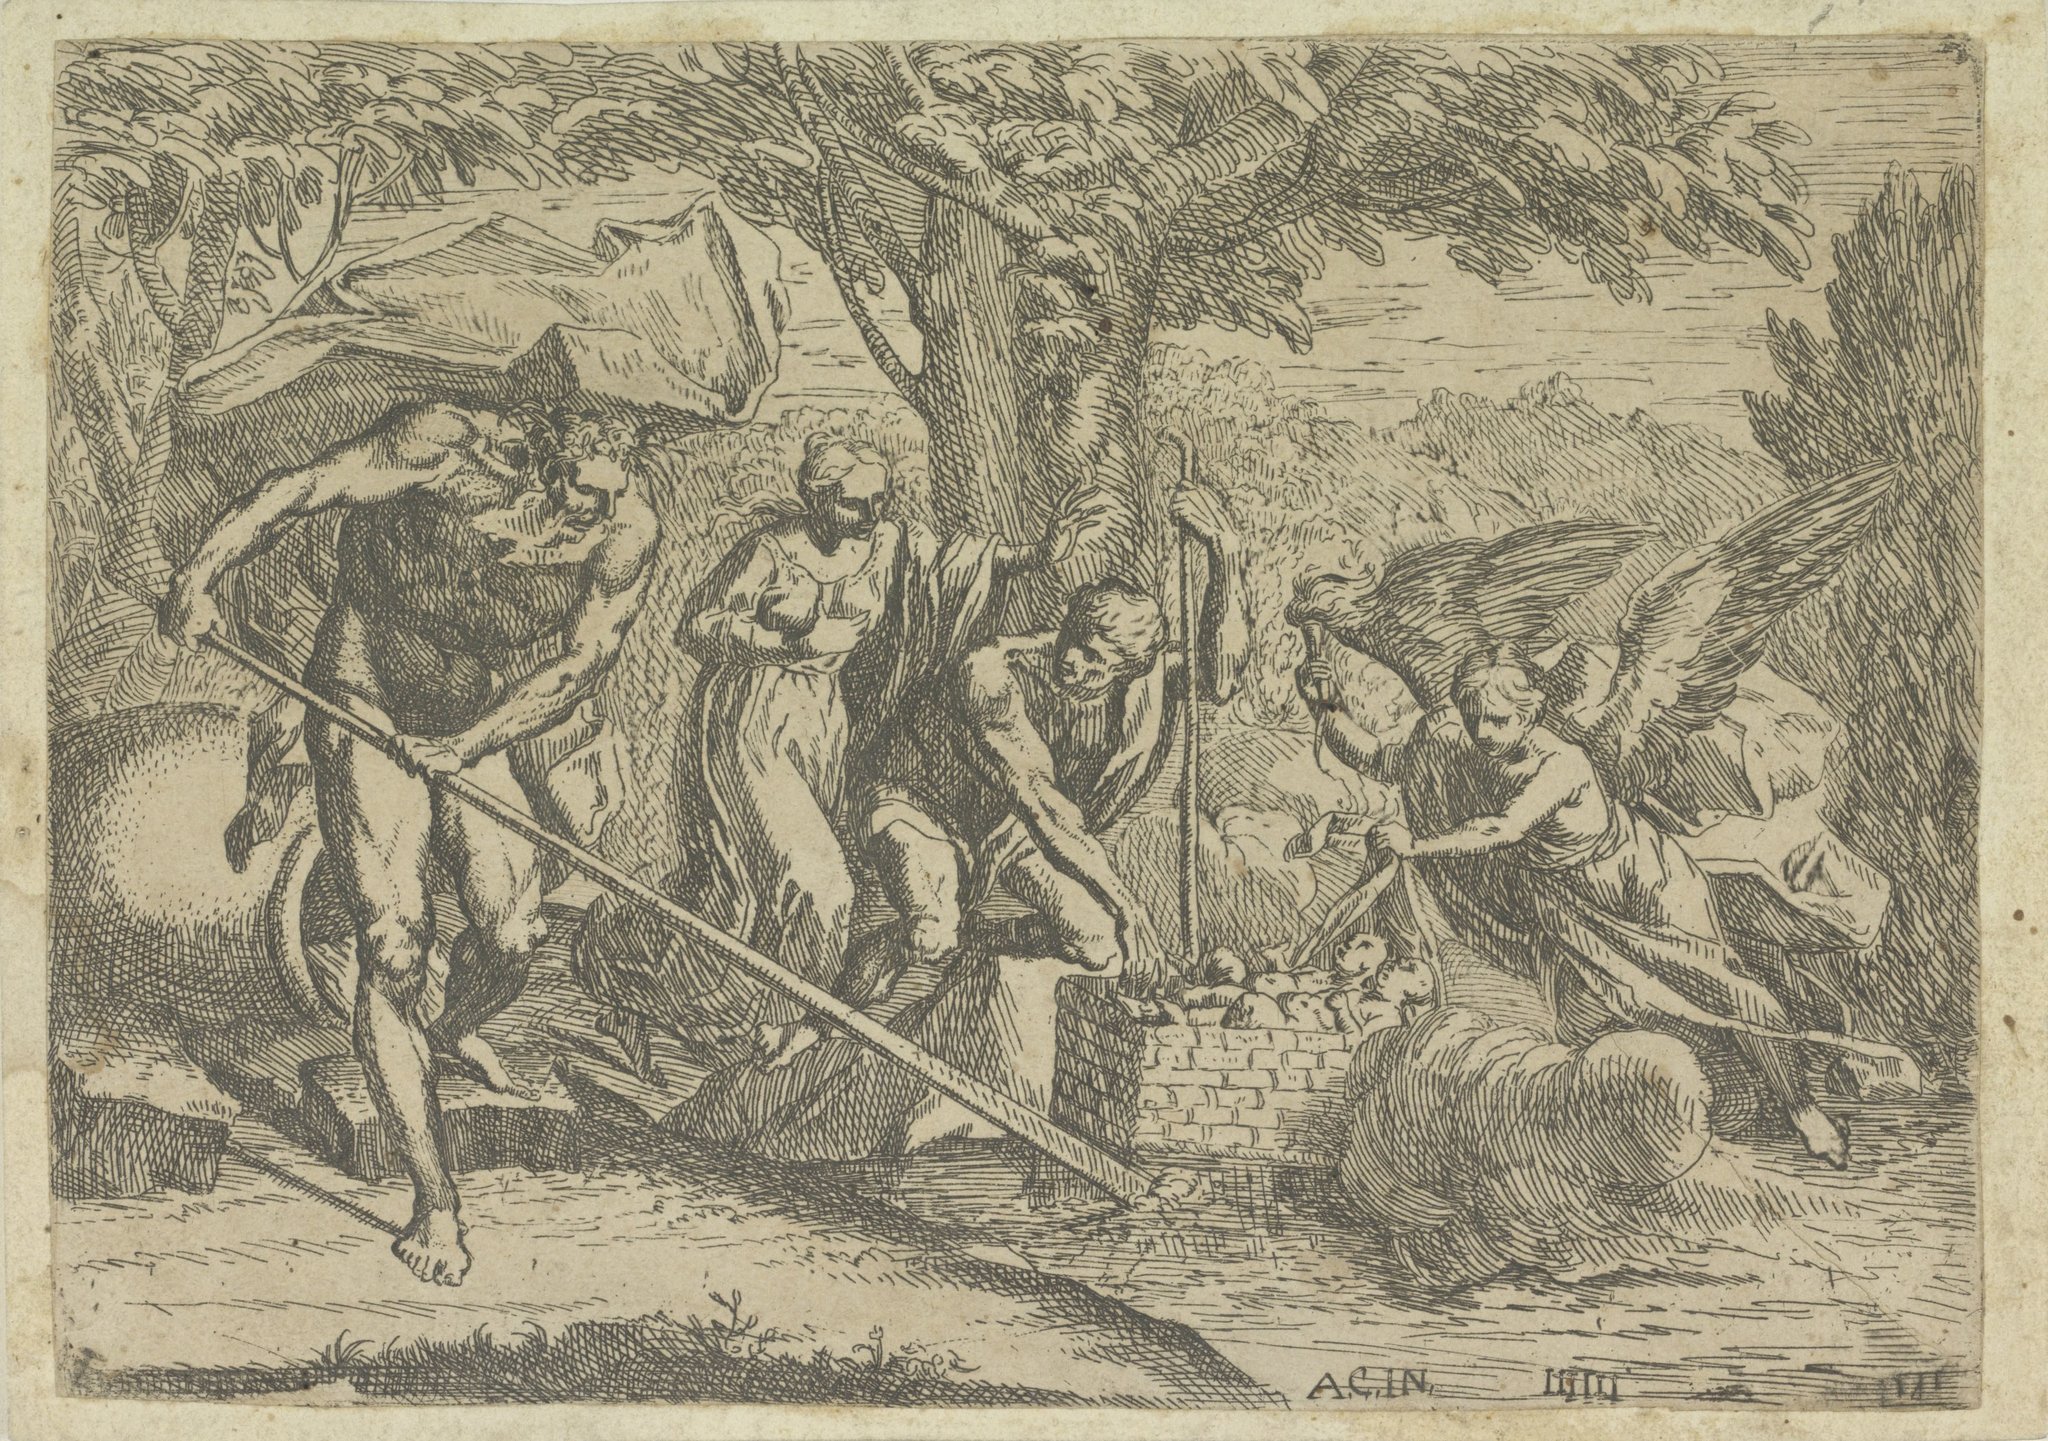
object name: print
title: Romulus en Remus gevonden door Faustulus en Louva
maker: marcantonio bellavia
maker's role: painter, print maker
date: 1660-1680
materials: paper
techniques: etching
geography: italy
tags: early life, prime youth of romulus and remus, the herdsman faustulus discovers romulus and remus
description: Romulus en Remus drijven in een mand op de rivier. Ze worden ontdekt door Faustulus en zijn vrouw Louva. Bij de mand een engel met een fakkel. Links een riviergod die de mand met een peddel naar de kant duwt. Genummerd rechtsonder: IIIIII.